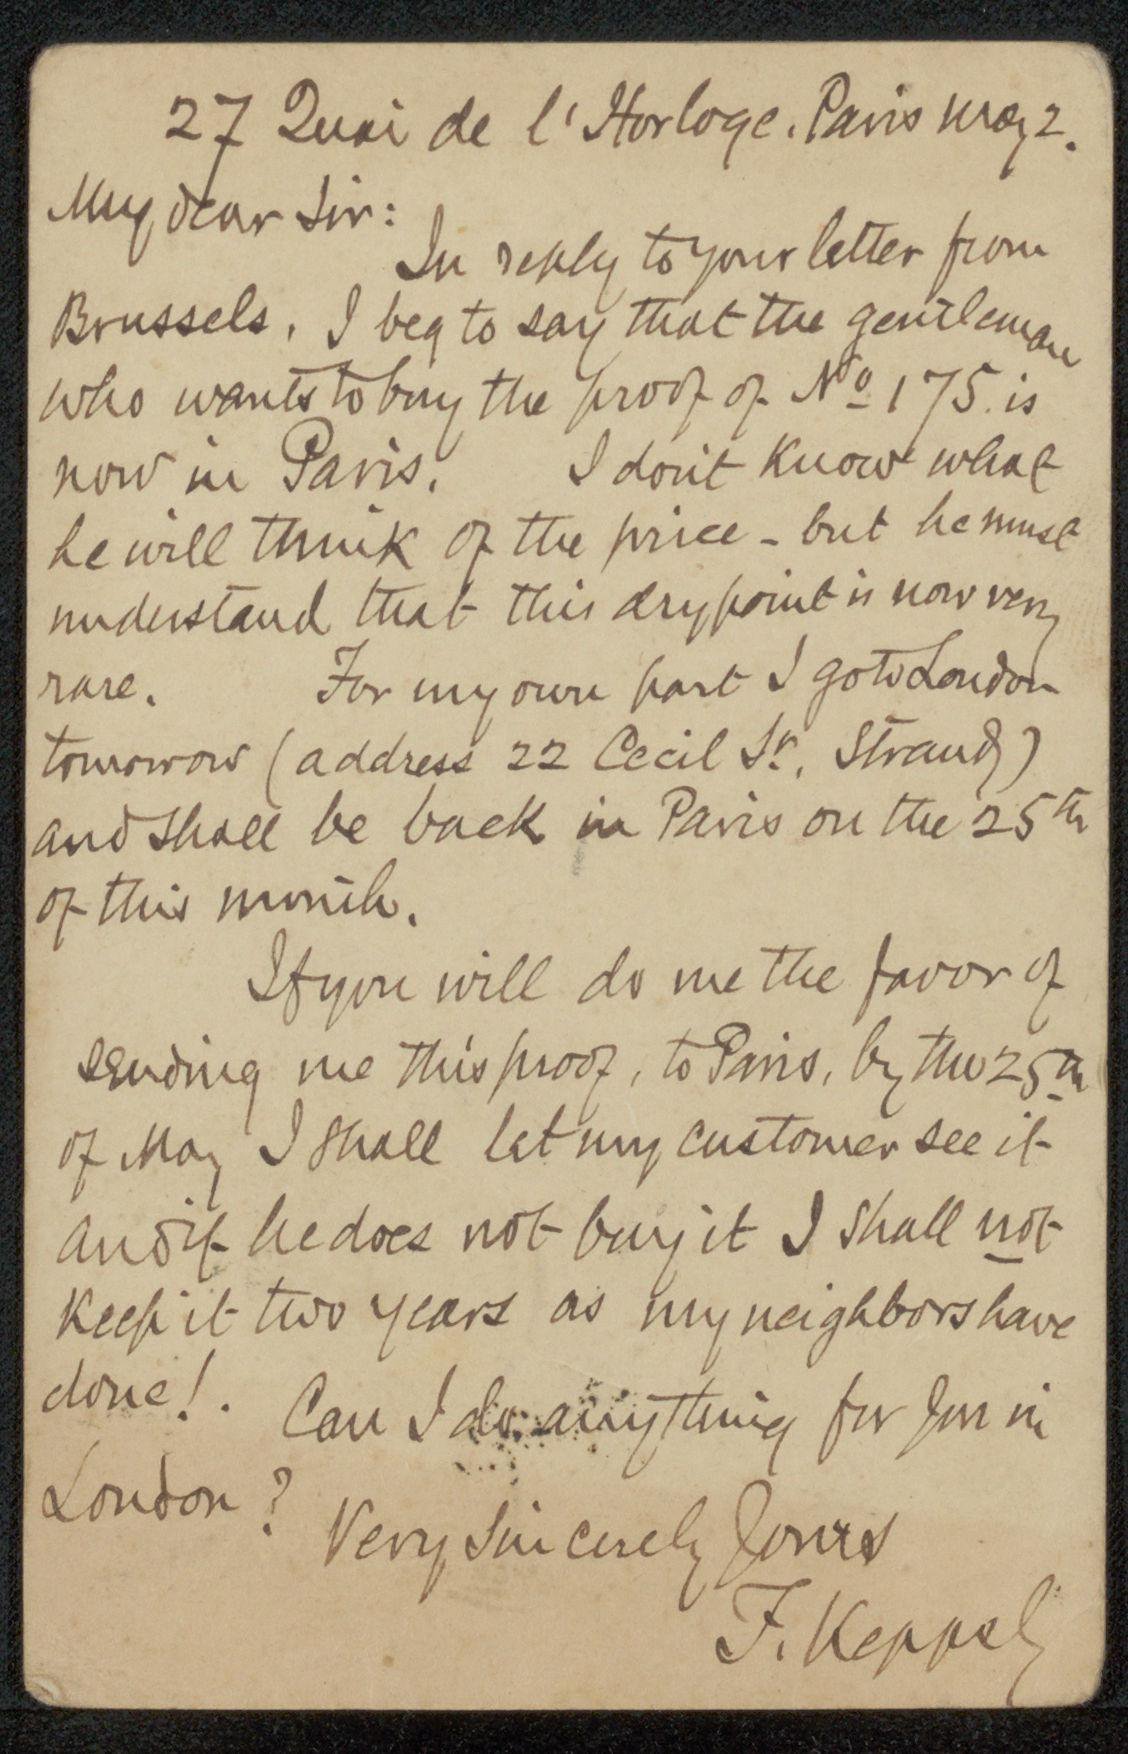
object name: postcard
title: Briefkaart aan Philip Zilcken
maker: frederick keppel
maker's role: criticus, kunsthandelaar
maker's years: 1845-1912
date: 1893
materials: cardboard, ink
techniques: pen, writing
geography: paris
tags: the hague, painter, draughtsman, philip zilcken, art trade, art shop, the graphic arts, london, paris